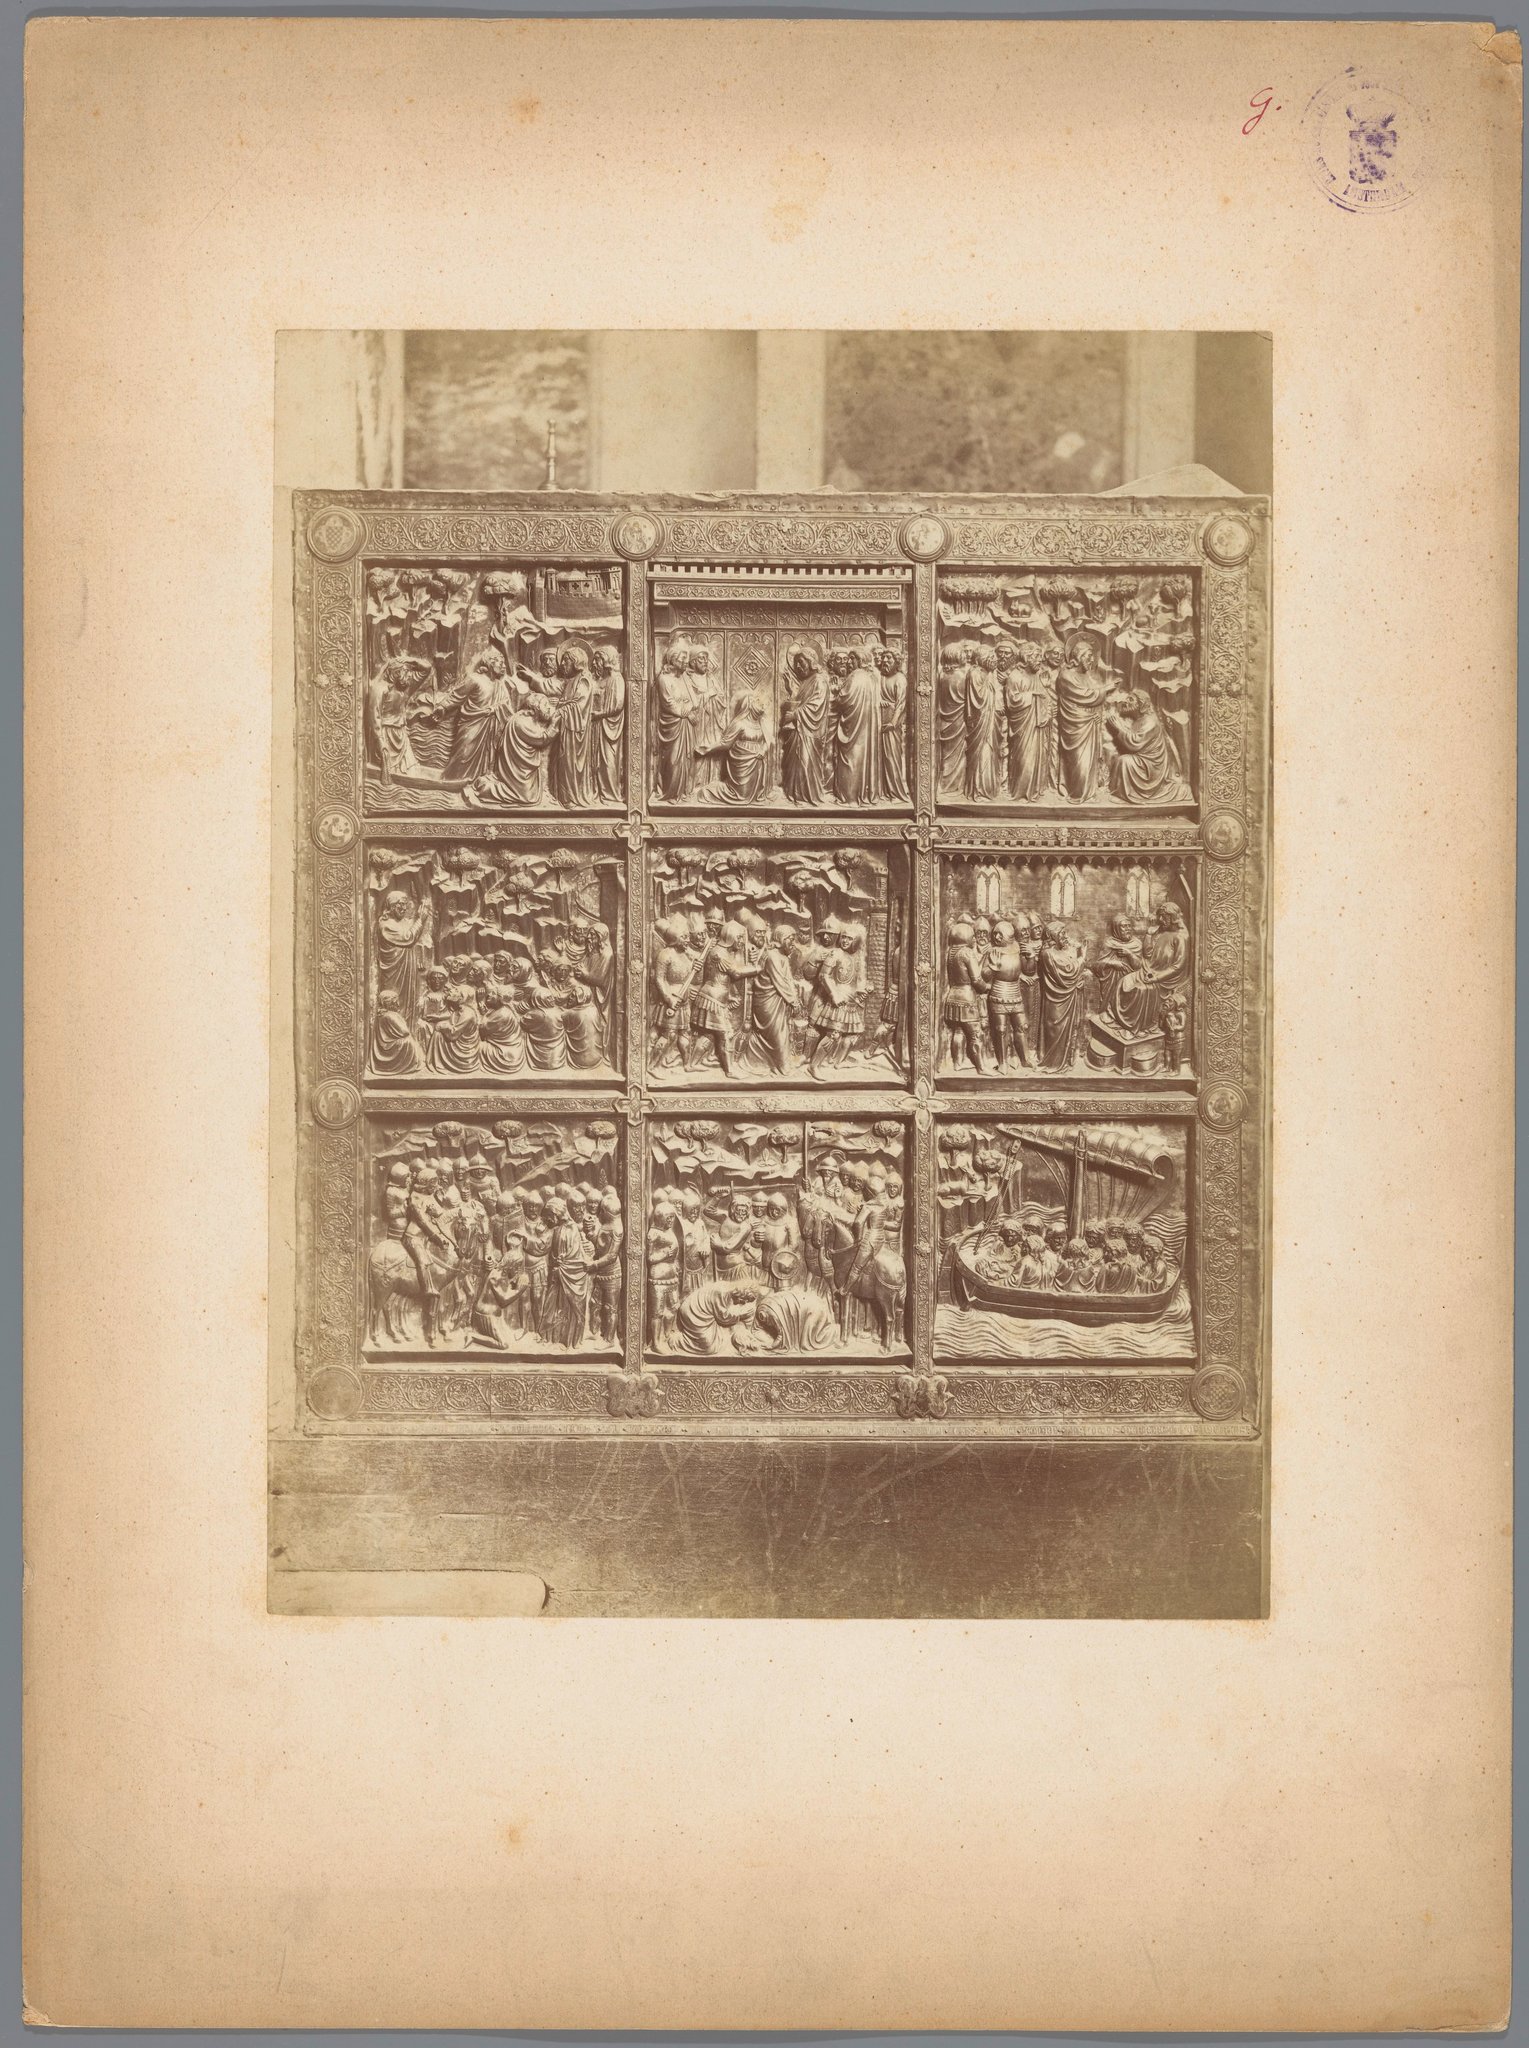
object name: photograph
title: Bronzen paneel met negen bijbelse voorstellingen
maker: Anonymous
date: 1850-1900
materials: cardboard, photographic support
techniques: albumen print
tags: series of scenes from the life of christ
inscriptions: inscription: ‘G’, collector's mark: ‘Rijks normaalschool voor teekenonderwijzers Amsterdam’